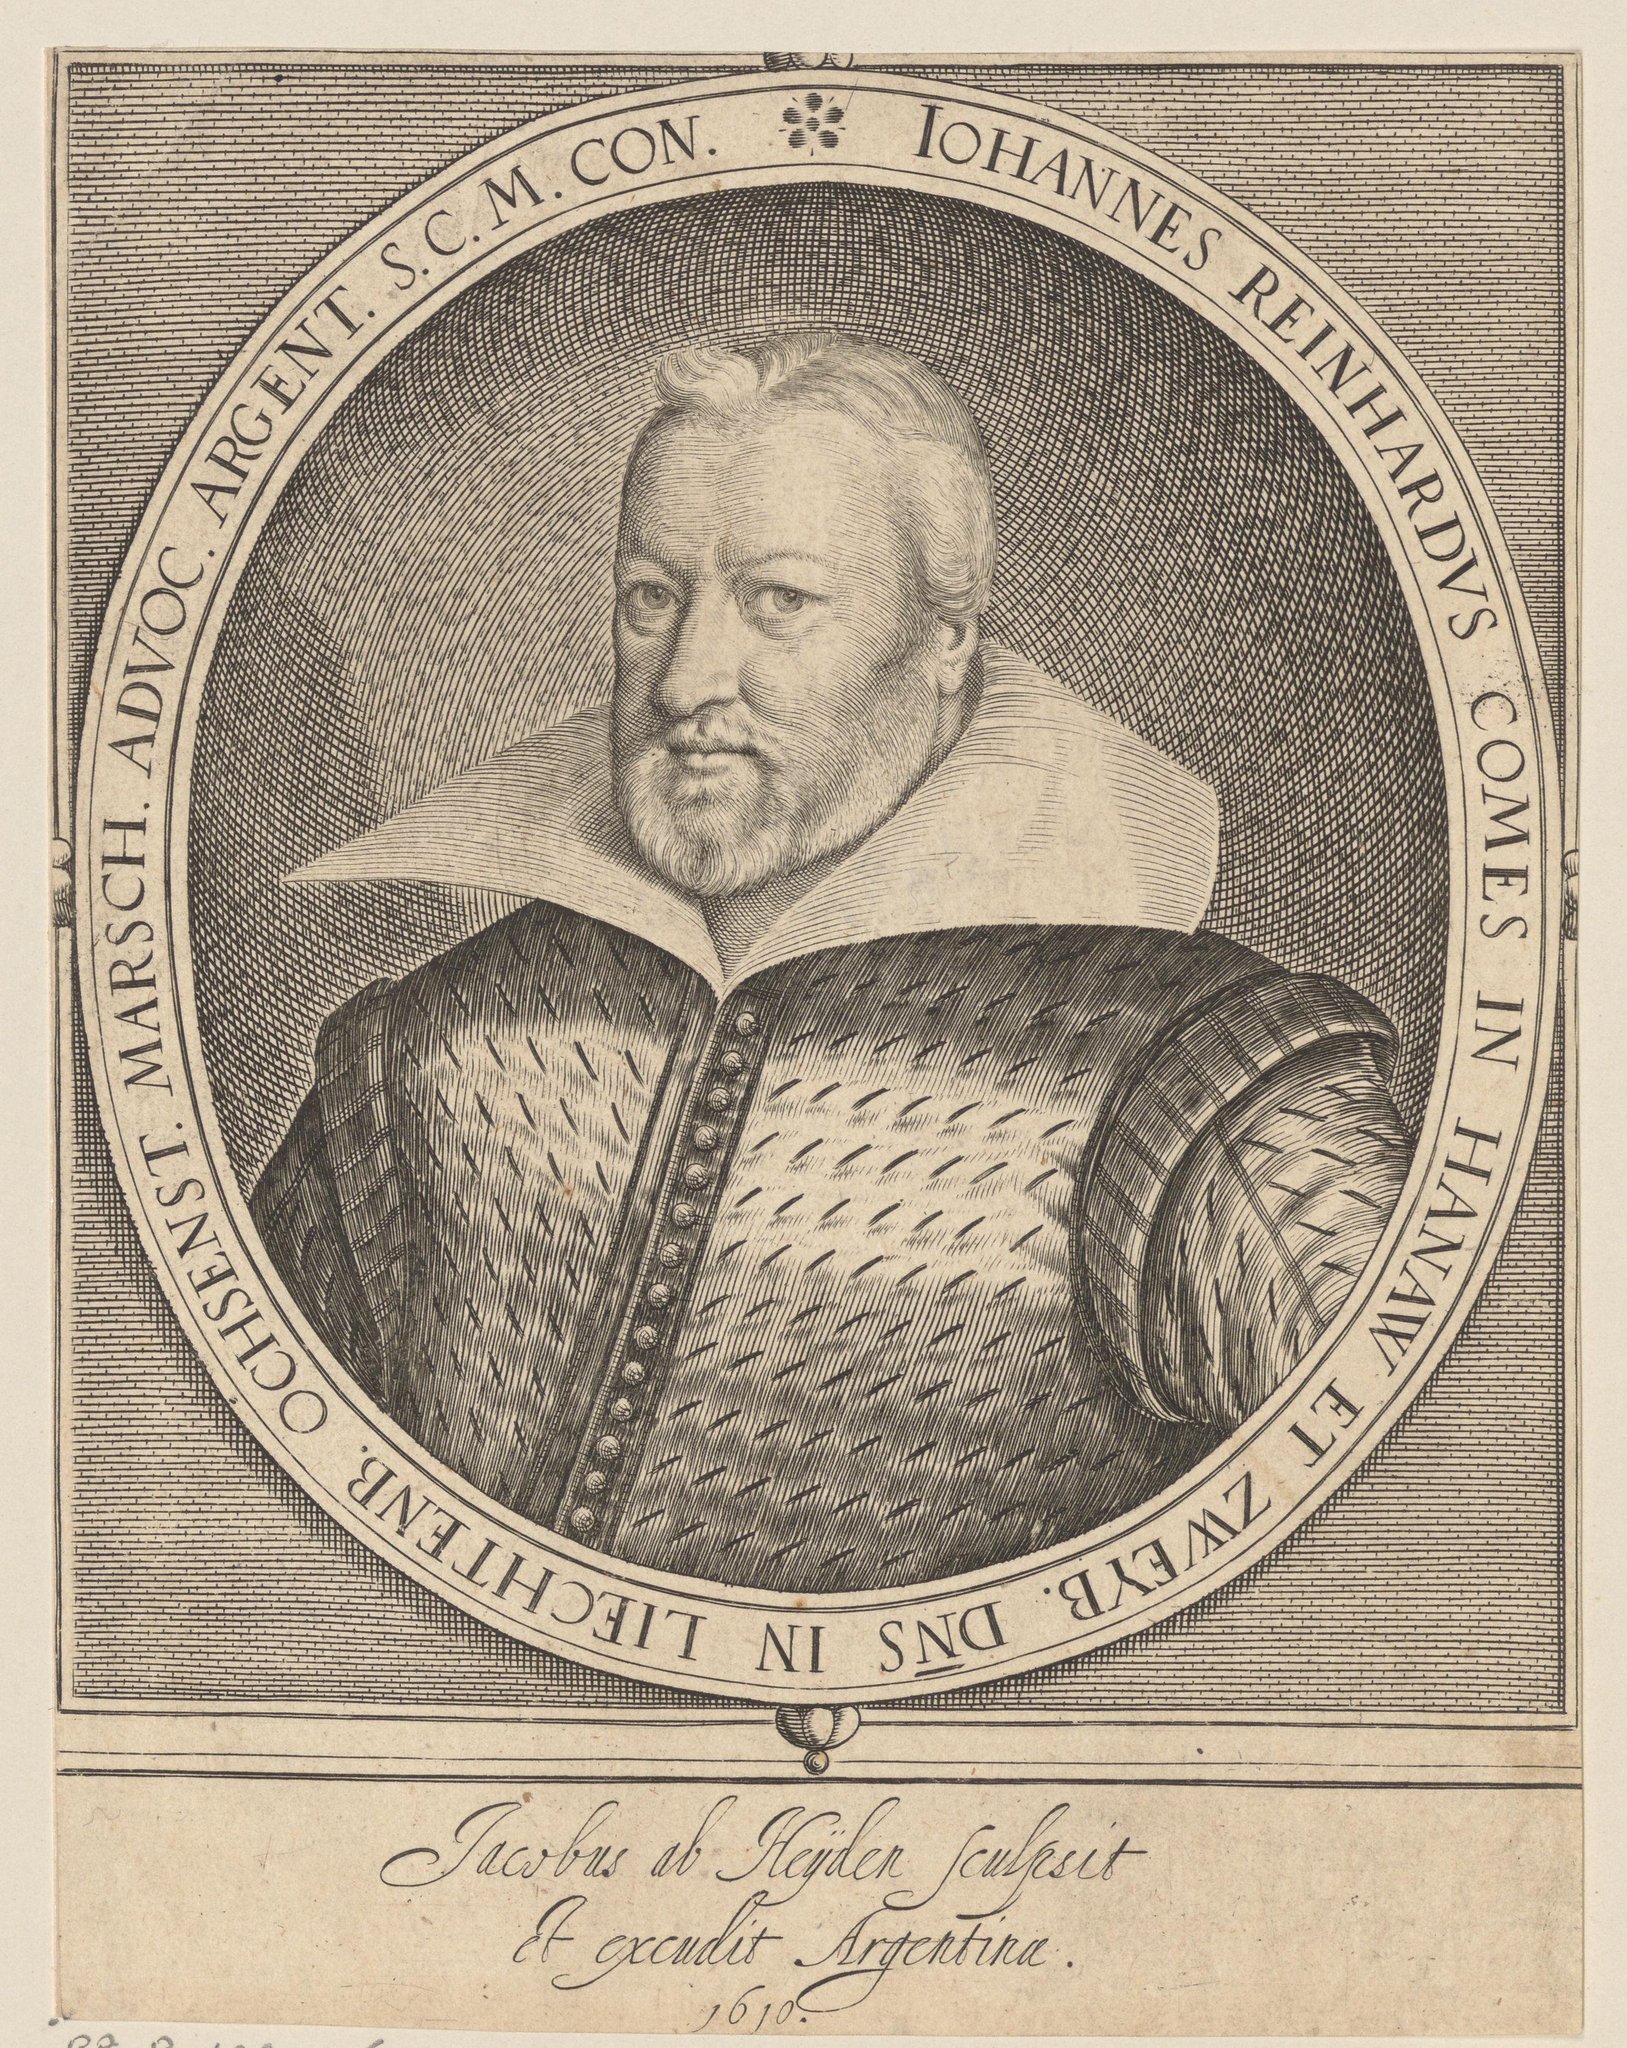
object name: print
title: Portret van Johann Reinhard I, graaf van Hanau-Lichtenberg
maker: jacob van der heyden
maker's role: draughtsman, print maker, publisher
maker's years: 1573-1645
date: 1610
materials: paper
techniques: engraving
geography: augsburg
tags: historical persons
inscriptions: collector's mark: Lugt 2228